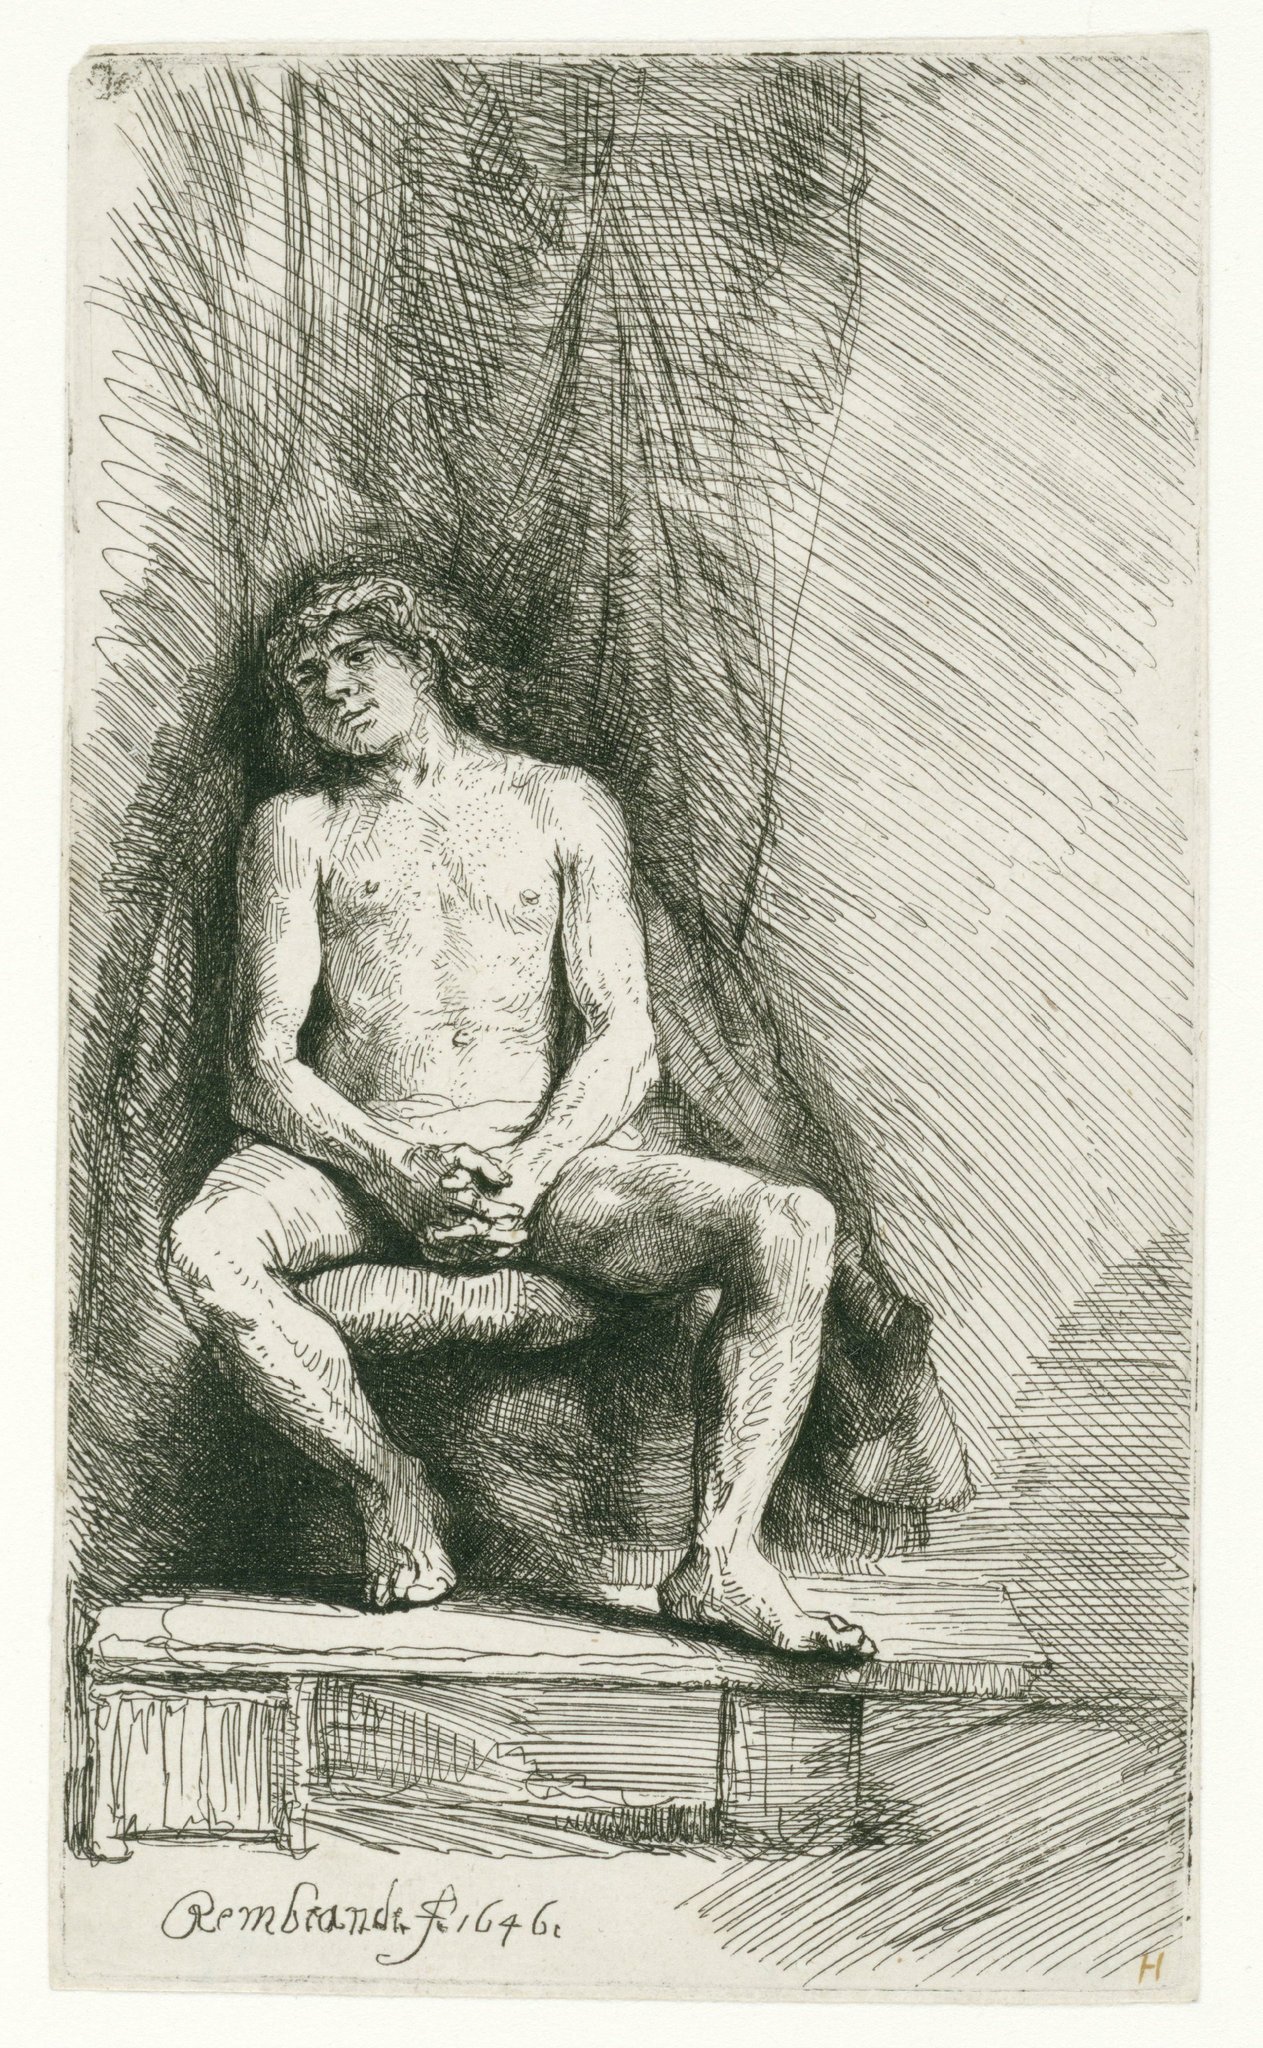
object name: print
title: Nude man seated before a curtain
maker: rembrandt van rijn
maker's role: draughtsman, painter, print maker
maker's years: 1606-1669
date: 1646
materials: paper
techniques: etching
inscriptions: collector's mark: Lugt 240, inscription: ‘H’, signature and date: ‘Rembrandt f. 1646’